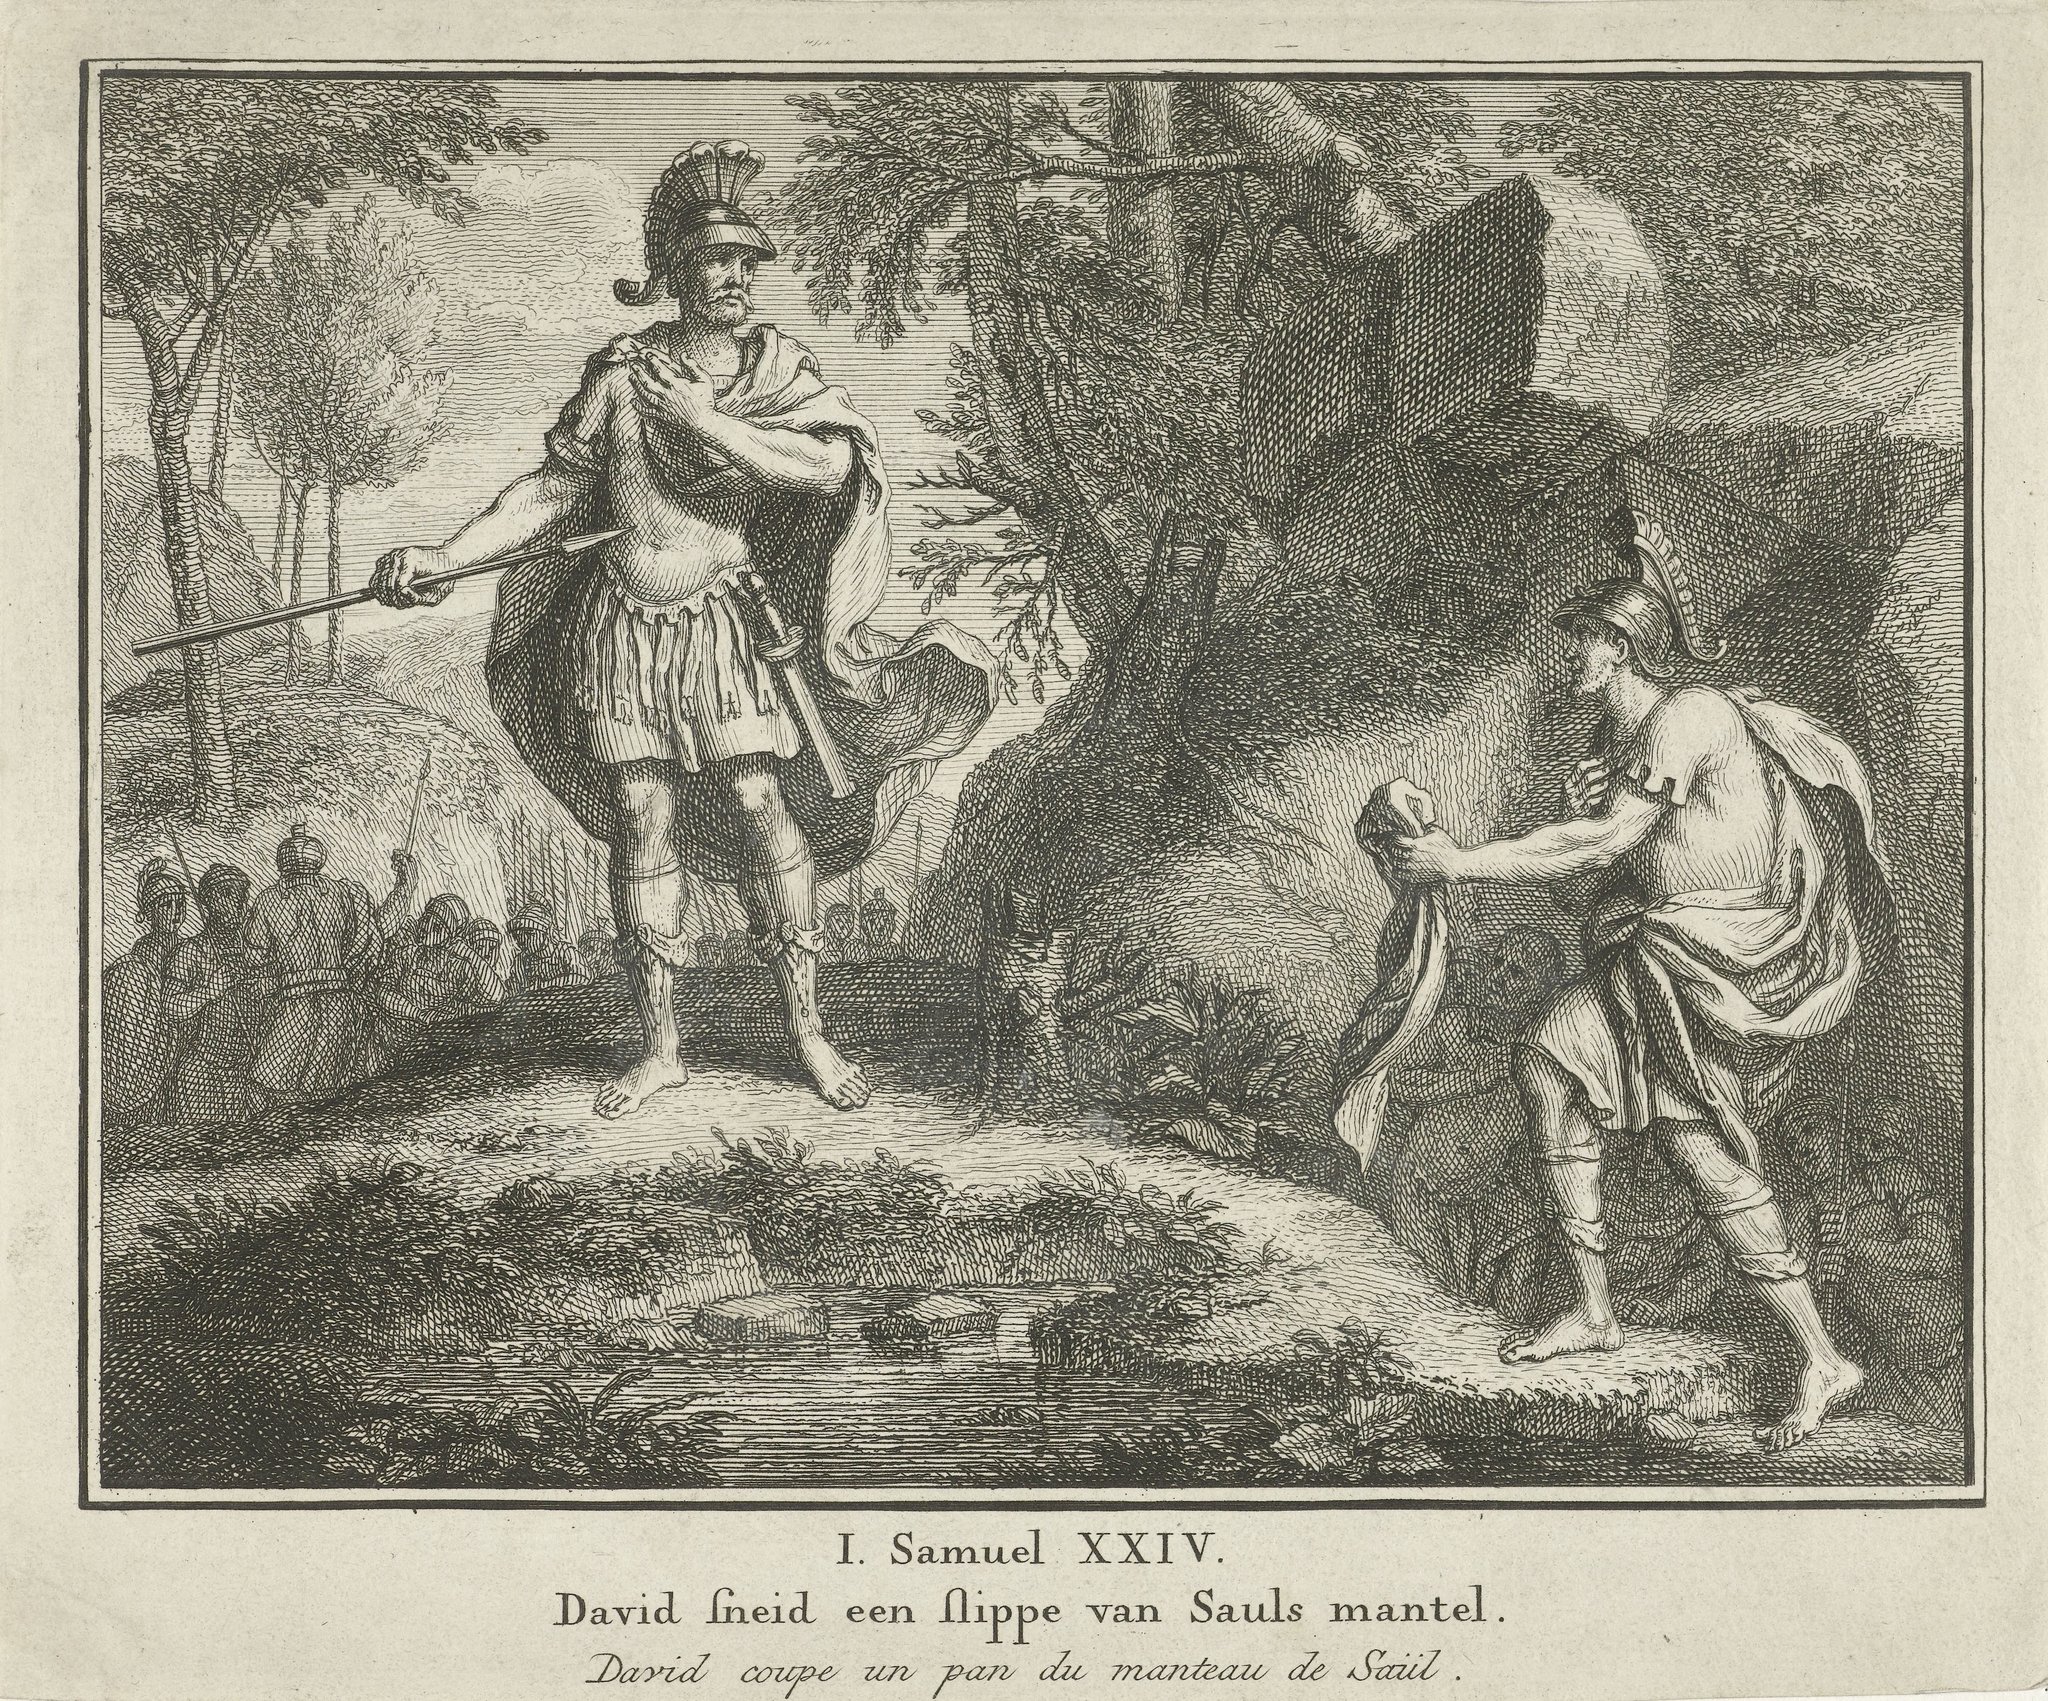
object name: print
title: David toont Saul het stuk van zijn mantel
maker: jacob folkema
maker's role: draughtsman, print maker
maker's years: 1692-1767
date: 1702-1767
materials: paper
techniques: etching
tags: when saul comes out of the cave, david calls him, falls down on his knees and shows him the piece of cloth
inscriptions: collector's mark: Lugt 2228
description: Bijbelse voorstelling uit 1 Sam. 24. David weerhoudt zijn mannen ervan om Saul te doden. Hij toont de verraste Saul een stuk van diens mantel dat hij eerder afgesneden heeft. Onder de voorstelling staat de titel in het Nederlands en Frans. De titel omschrijft een gebeurtenis die eerder plaatsvond, namelijk het afsnijden van een stuk van Saul's mantel.